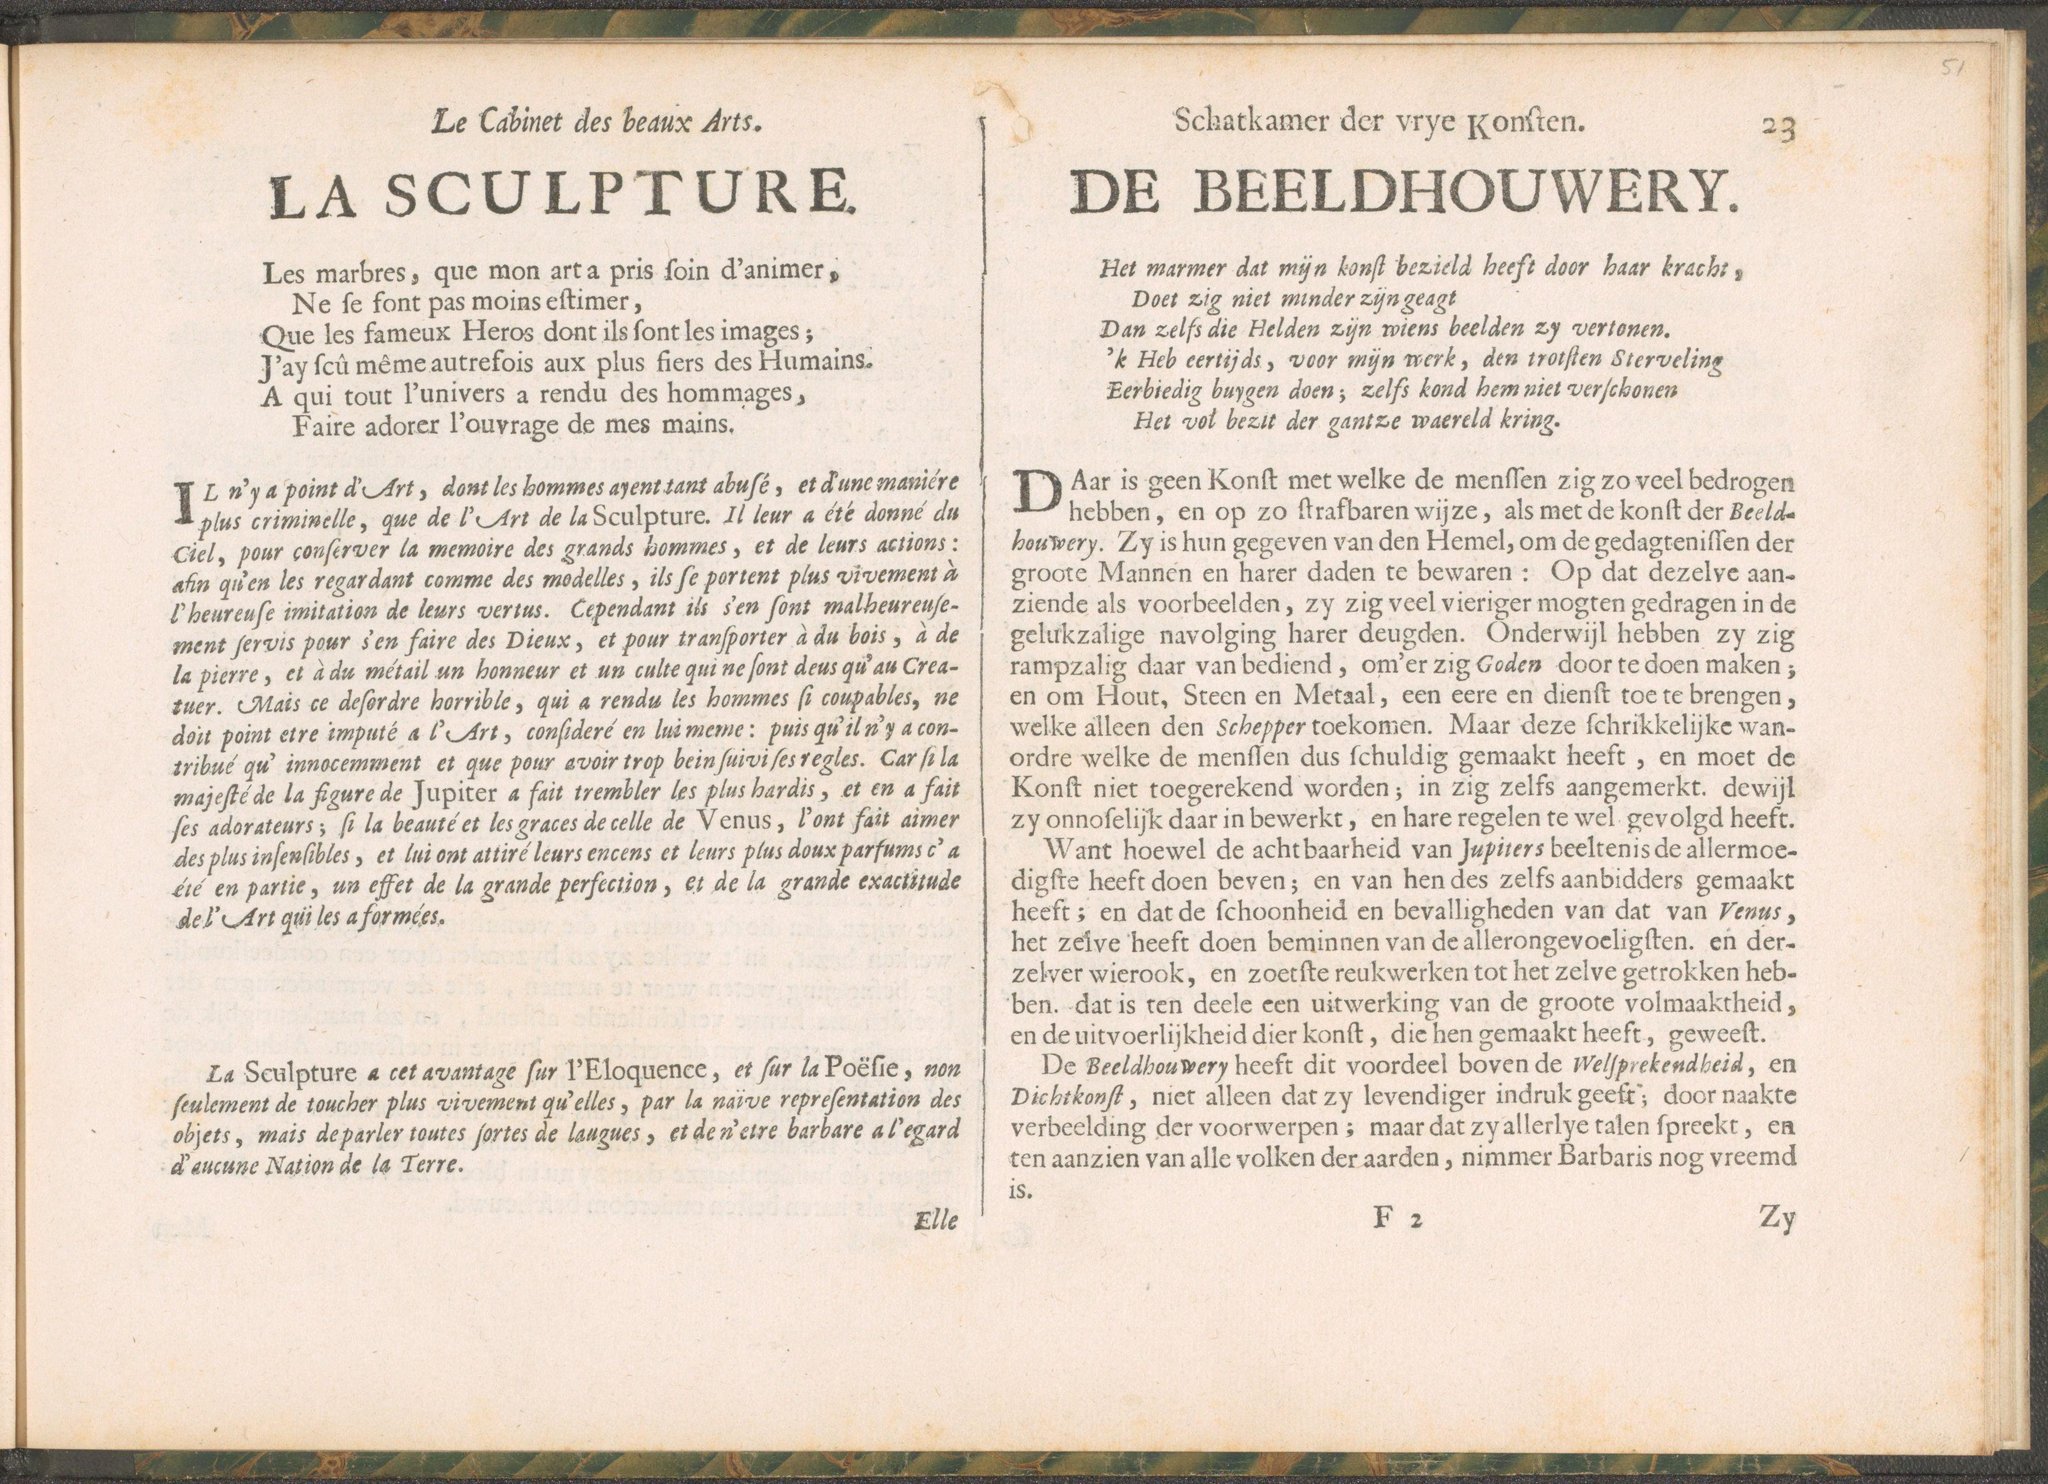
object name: text sheet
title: Tekstblad over de Beeldhouwkunst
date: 1693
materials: paper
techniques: letterpress printing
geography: amsterdam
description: Verklaring van de prent met de voorstelling van de personificatie van Beeldhouwkunst in het Frans en het Nederlands, pagina 23. Tekstblad maakt deel uit van een album.